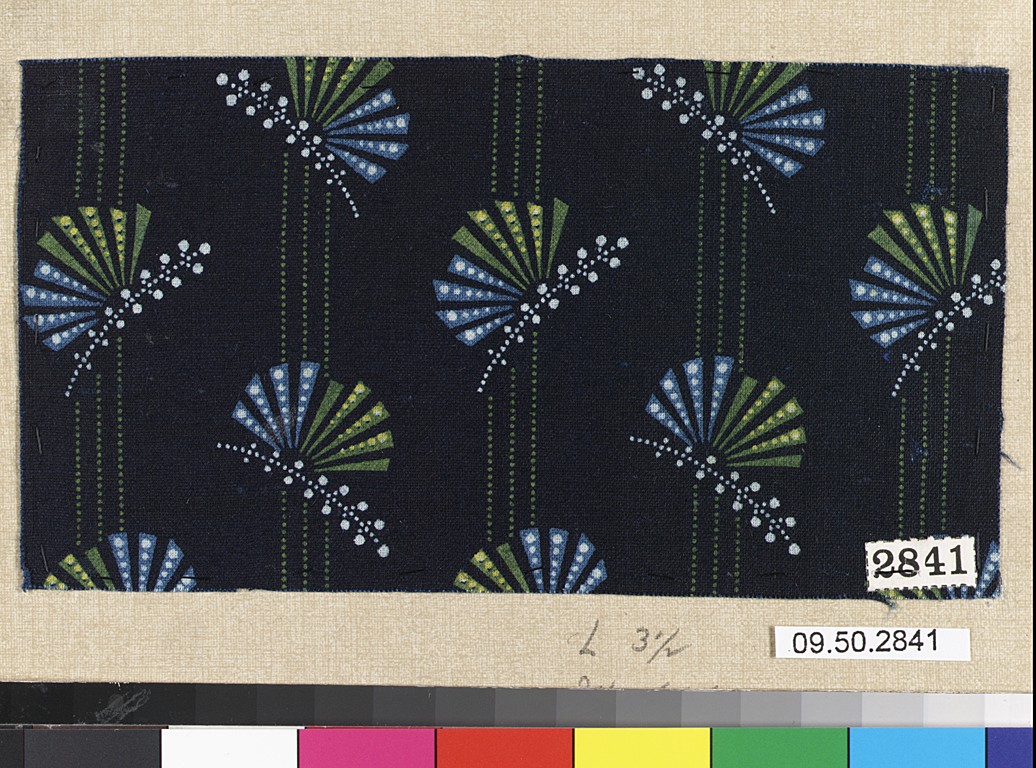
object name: piece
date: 1801-1900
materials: cotton